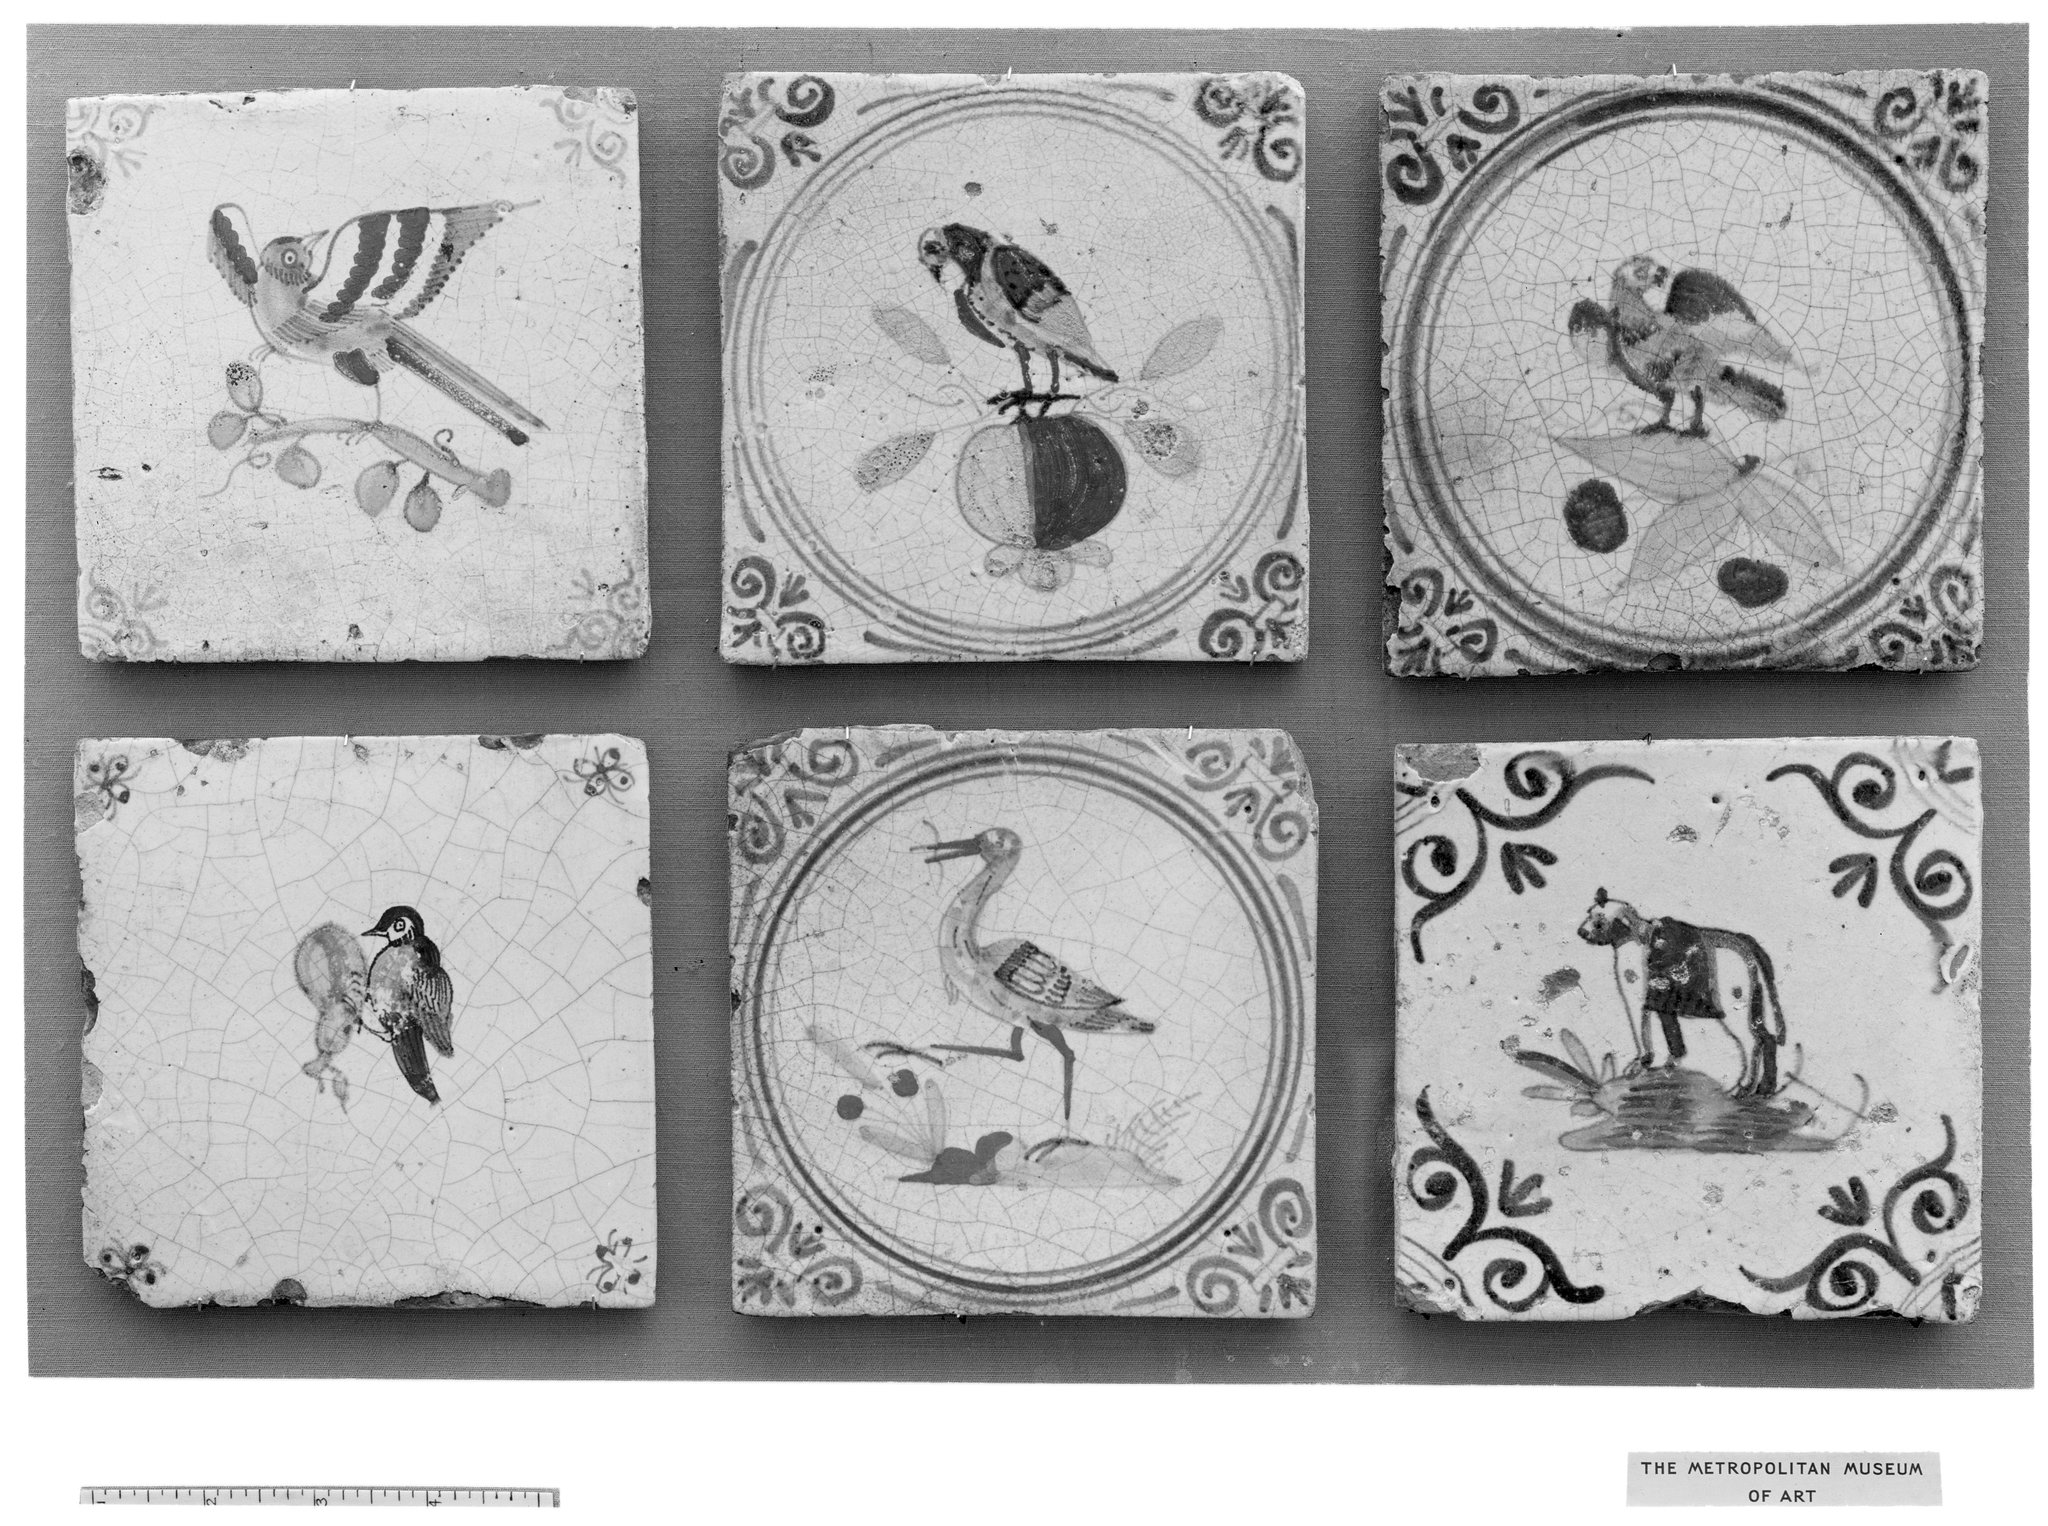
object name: tile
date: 1640-1660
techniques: glazing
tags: animals,birds